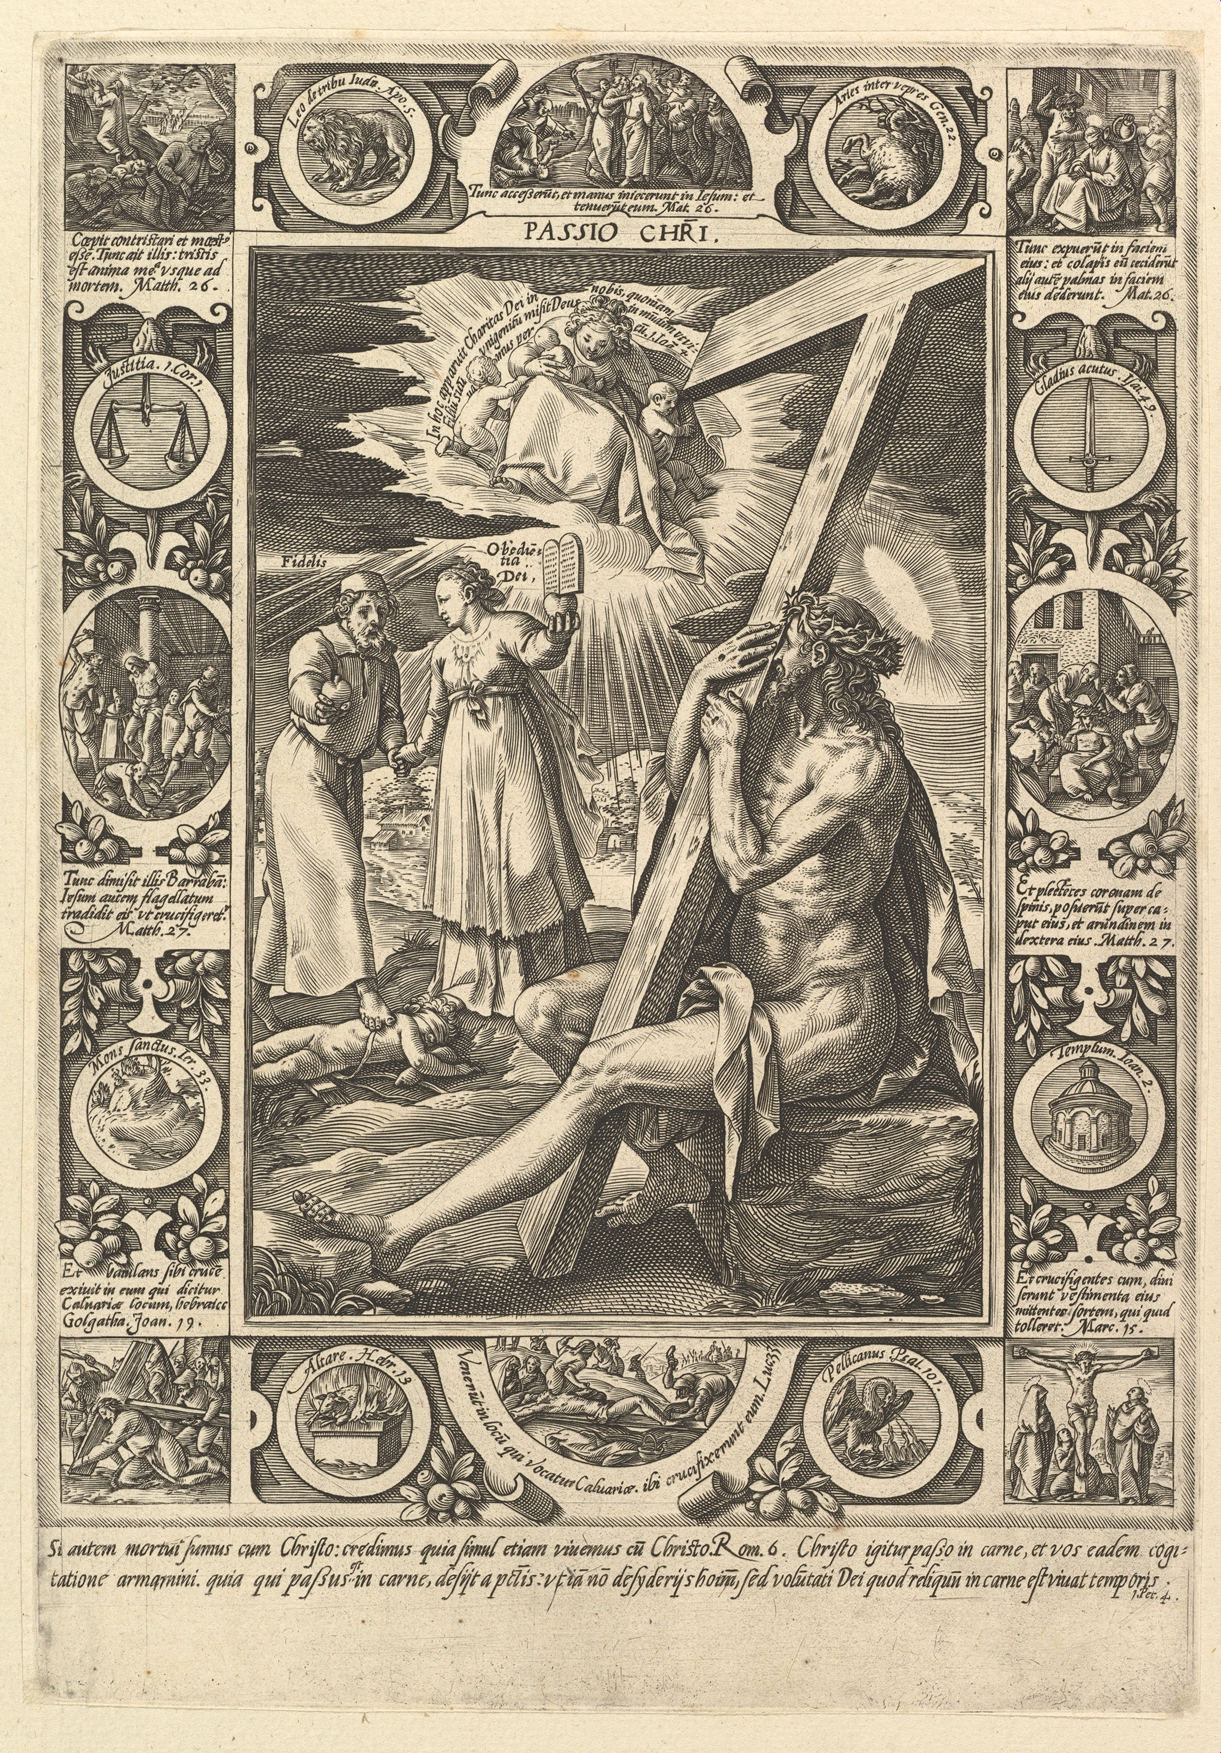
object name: print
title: Passio Christi, from the "Allegorical Scenes from the Life of Christ"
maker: hendrick goltzius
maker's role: artist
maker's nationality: netherlandish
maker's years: 1558-1617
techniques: engraving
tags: men,women,christ,cross